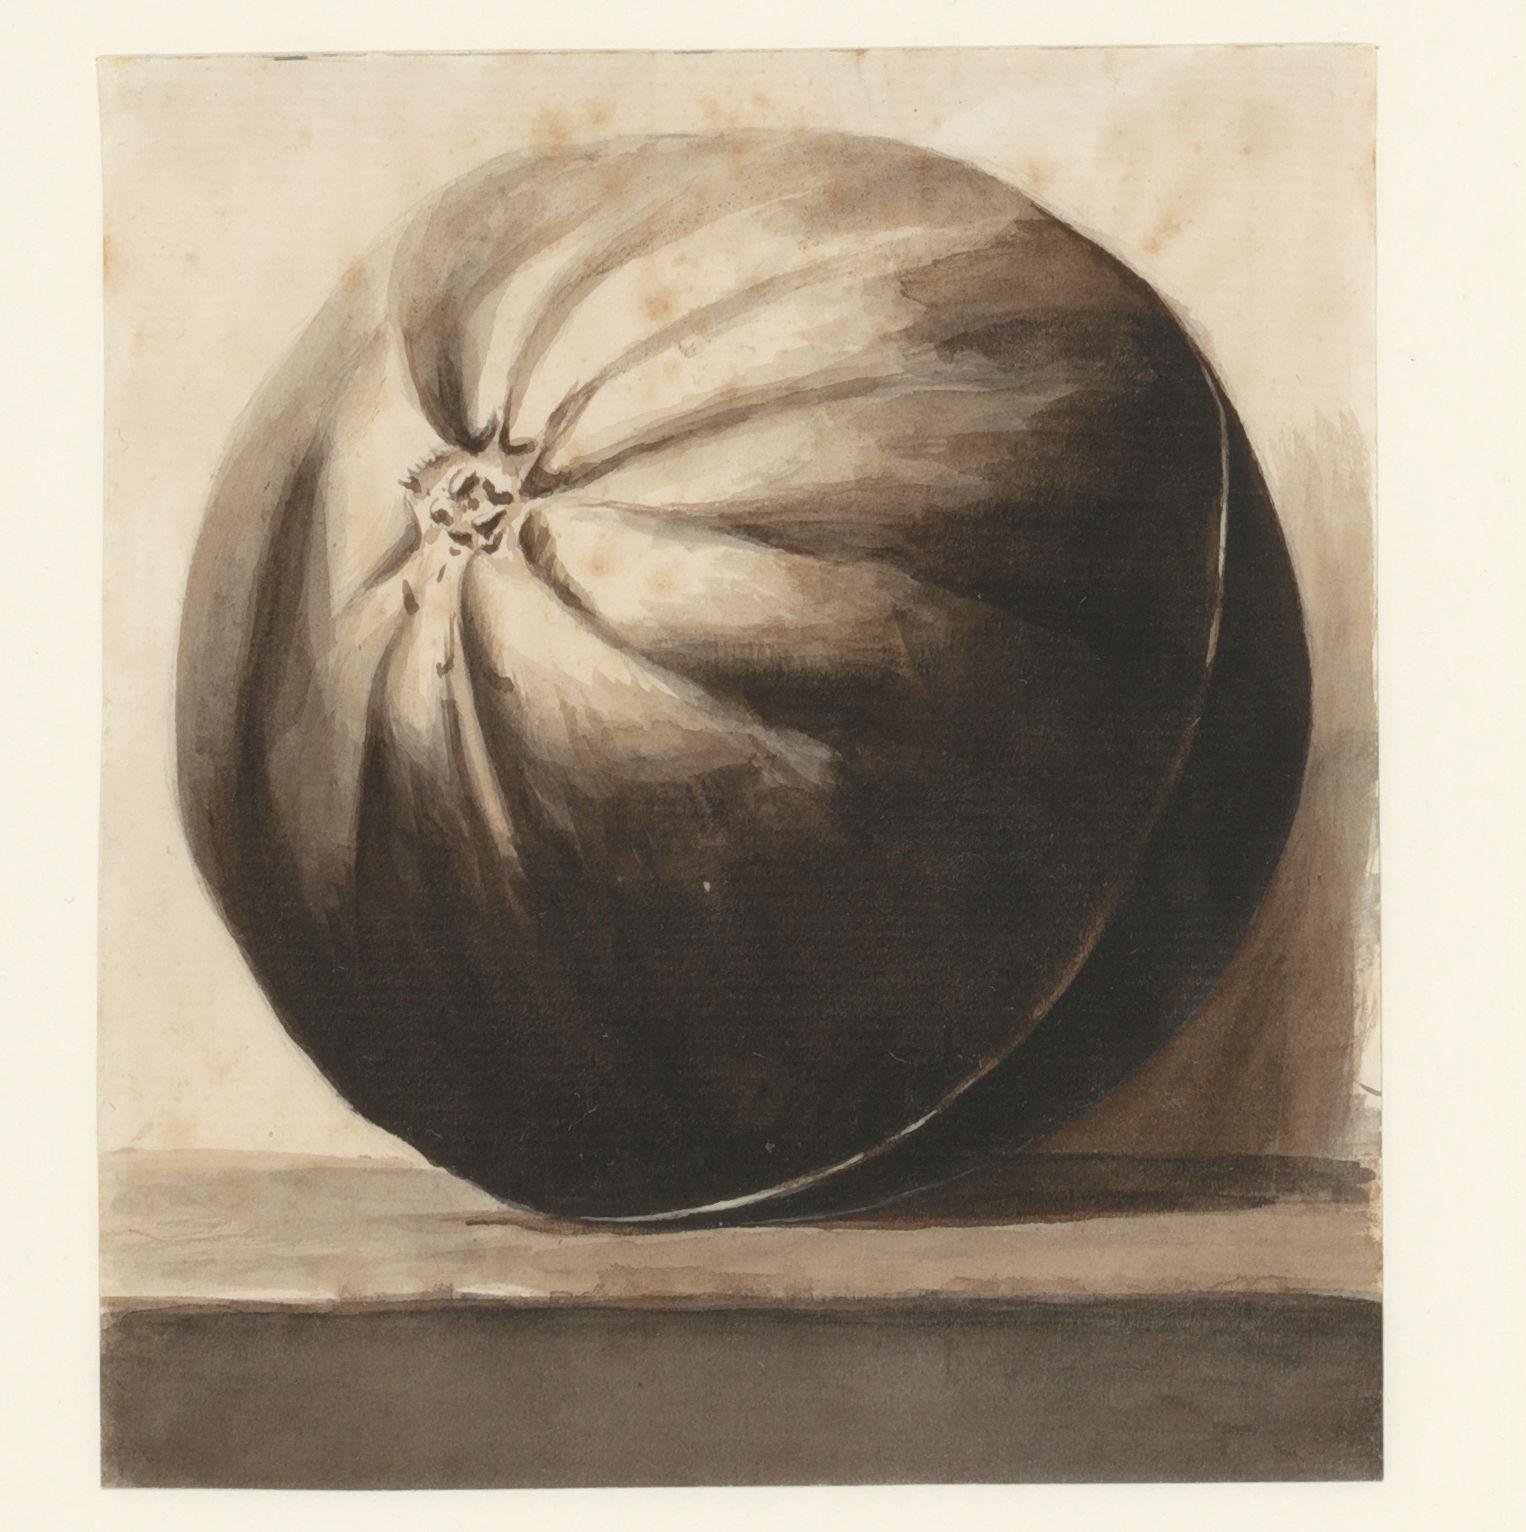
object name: drawing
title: Gebedsnoot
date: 1887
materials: ink, paper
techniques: brush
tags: carving ~ applied arts, piece of sculpture, reproduction of a piece of sculpture, wood carver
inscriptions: collector's mark: Lugt 1641, collector's mark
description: Gebedsnoot in gesloten toestand. De noot bevond zich in 1887 toen de tekening werd gemaakt, in de collectie van dhr. C. Becker te Frankfurt am Main. Onderwerpsrubrieken binnen de Atlas Zeden en Gewoonten: Beeldhouw- en snijkunst.